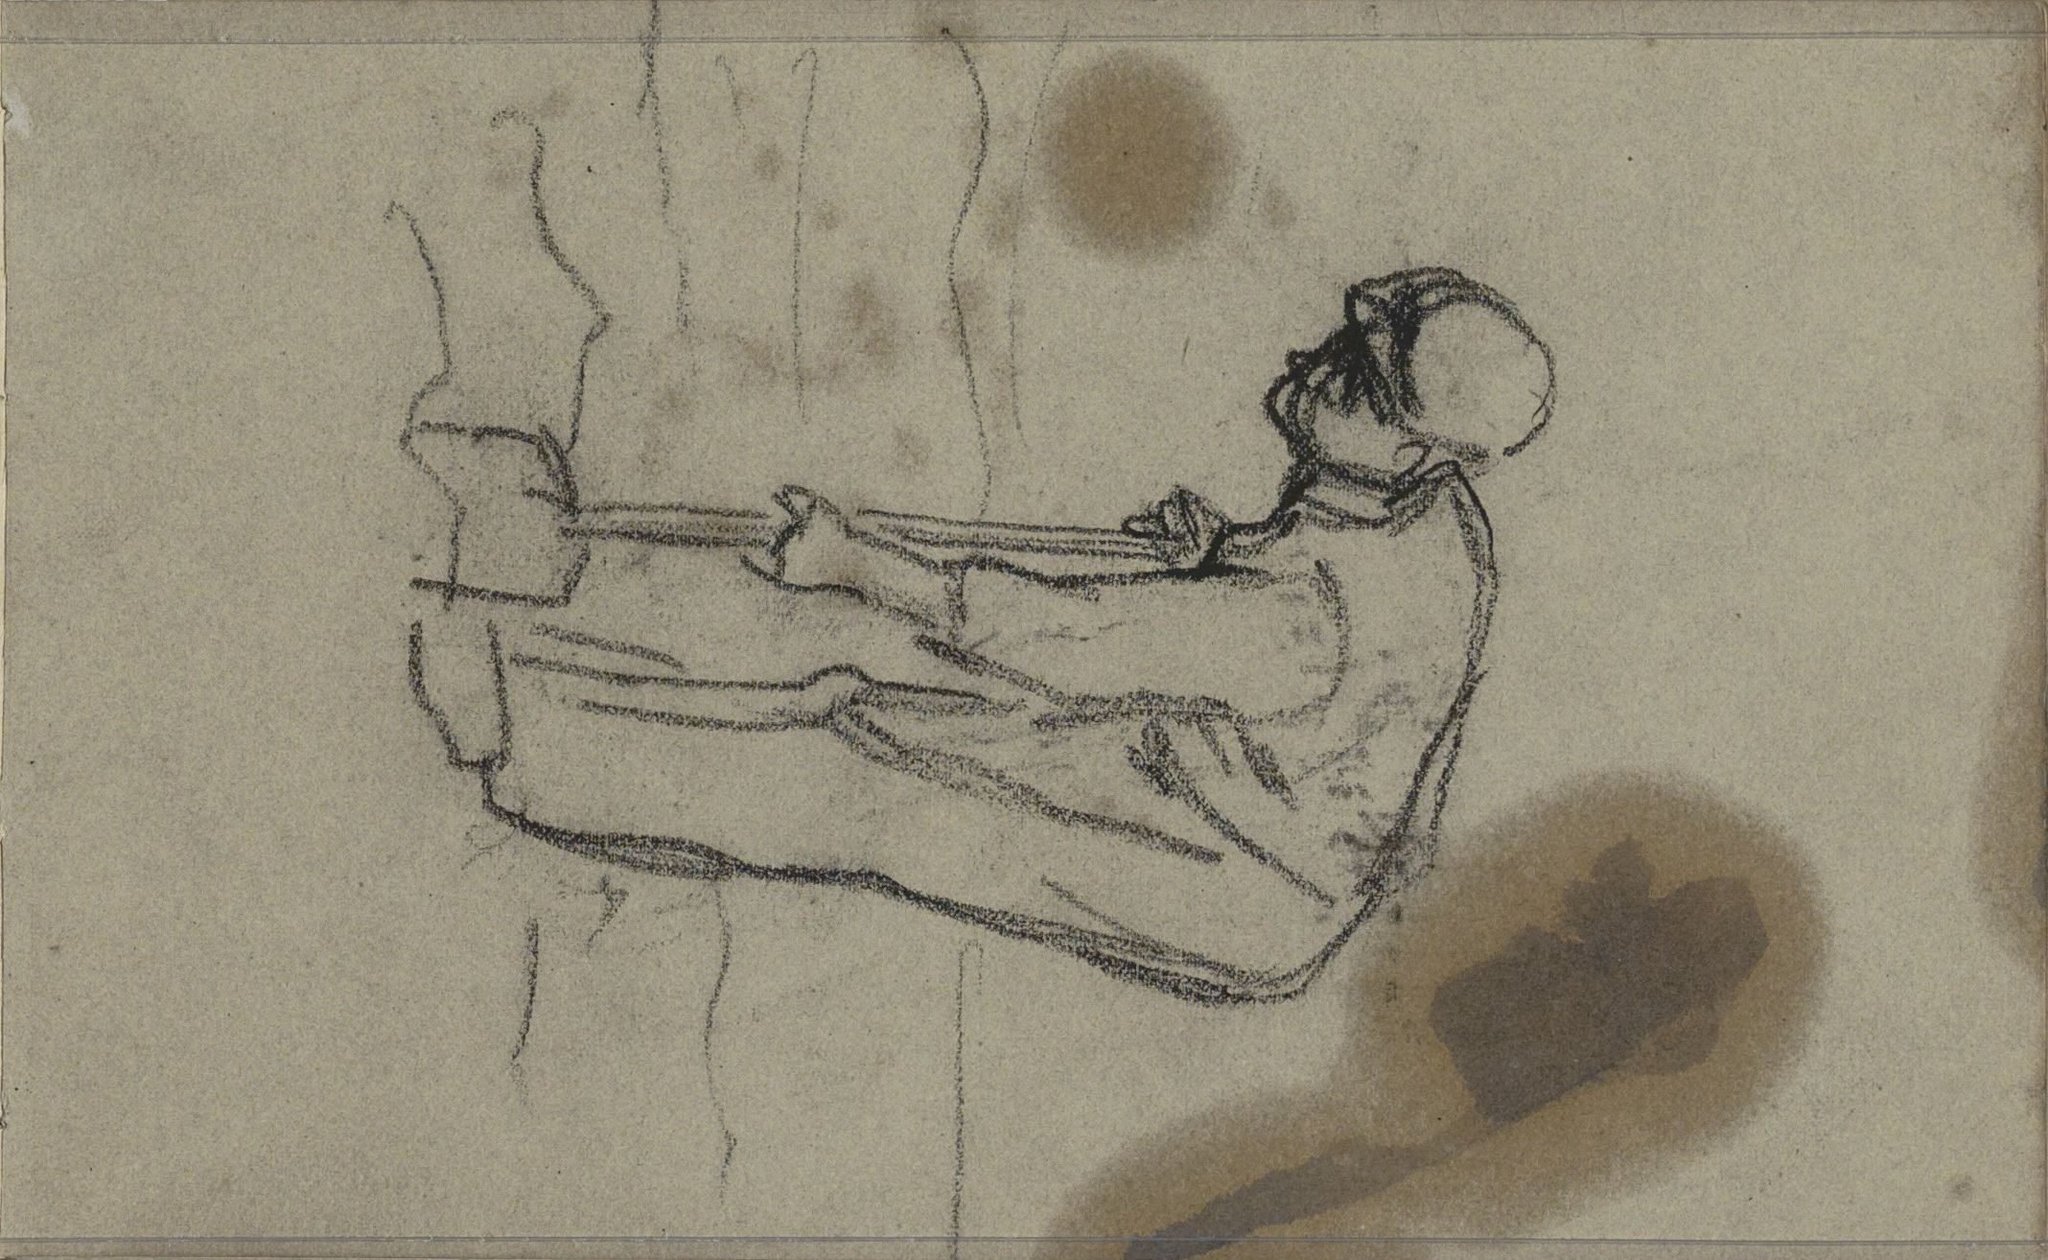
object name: sketchbook leaf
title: Spittende boer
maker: anton mauve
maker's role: draughtsman, painter, print maker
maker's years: 1838-1888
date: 1848-1888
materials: chalk, paper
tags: farmers, spading ~ soil cultivation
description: Blad 34 recto uit een schetsboek met 43 bladen.